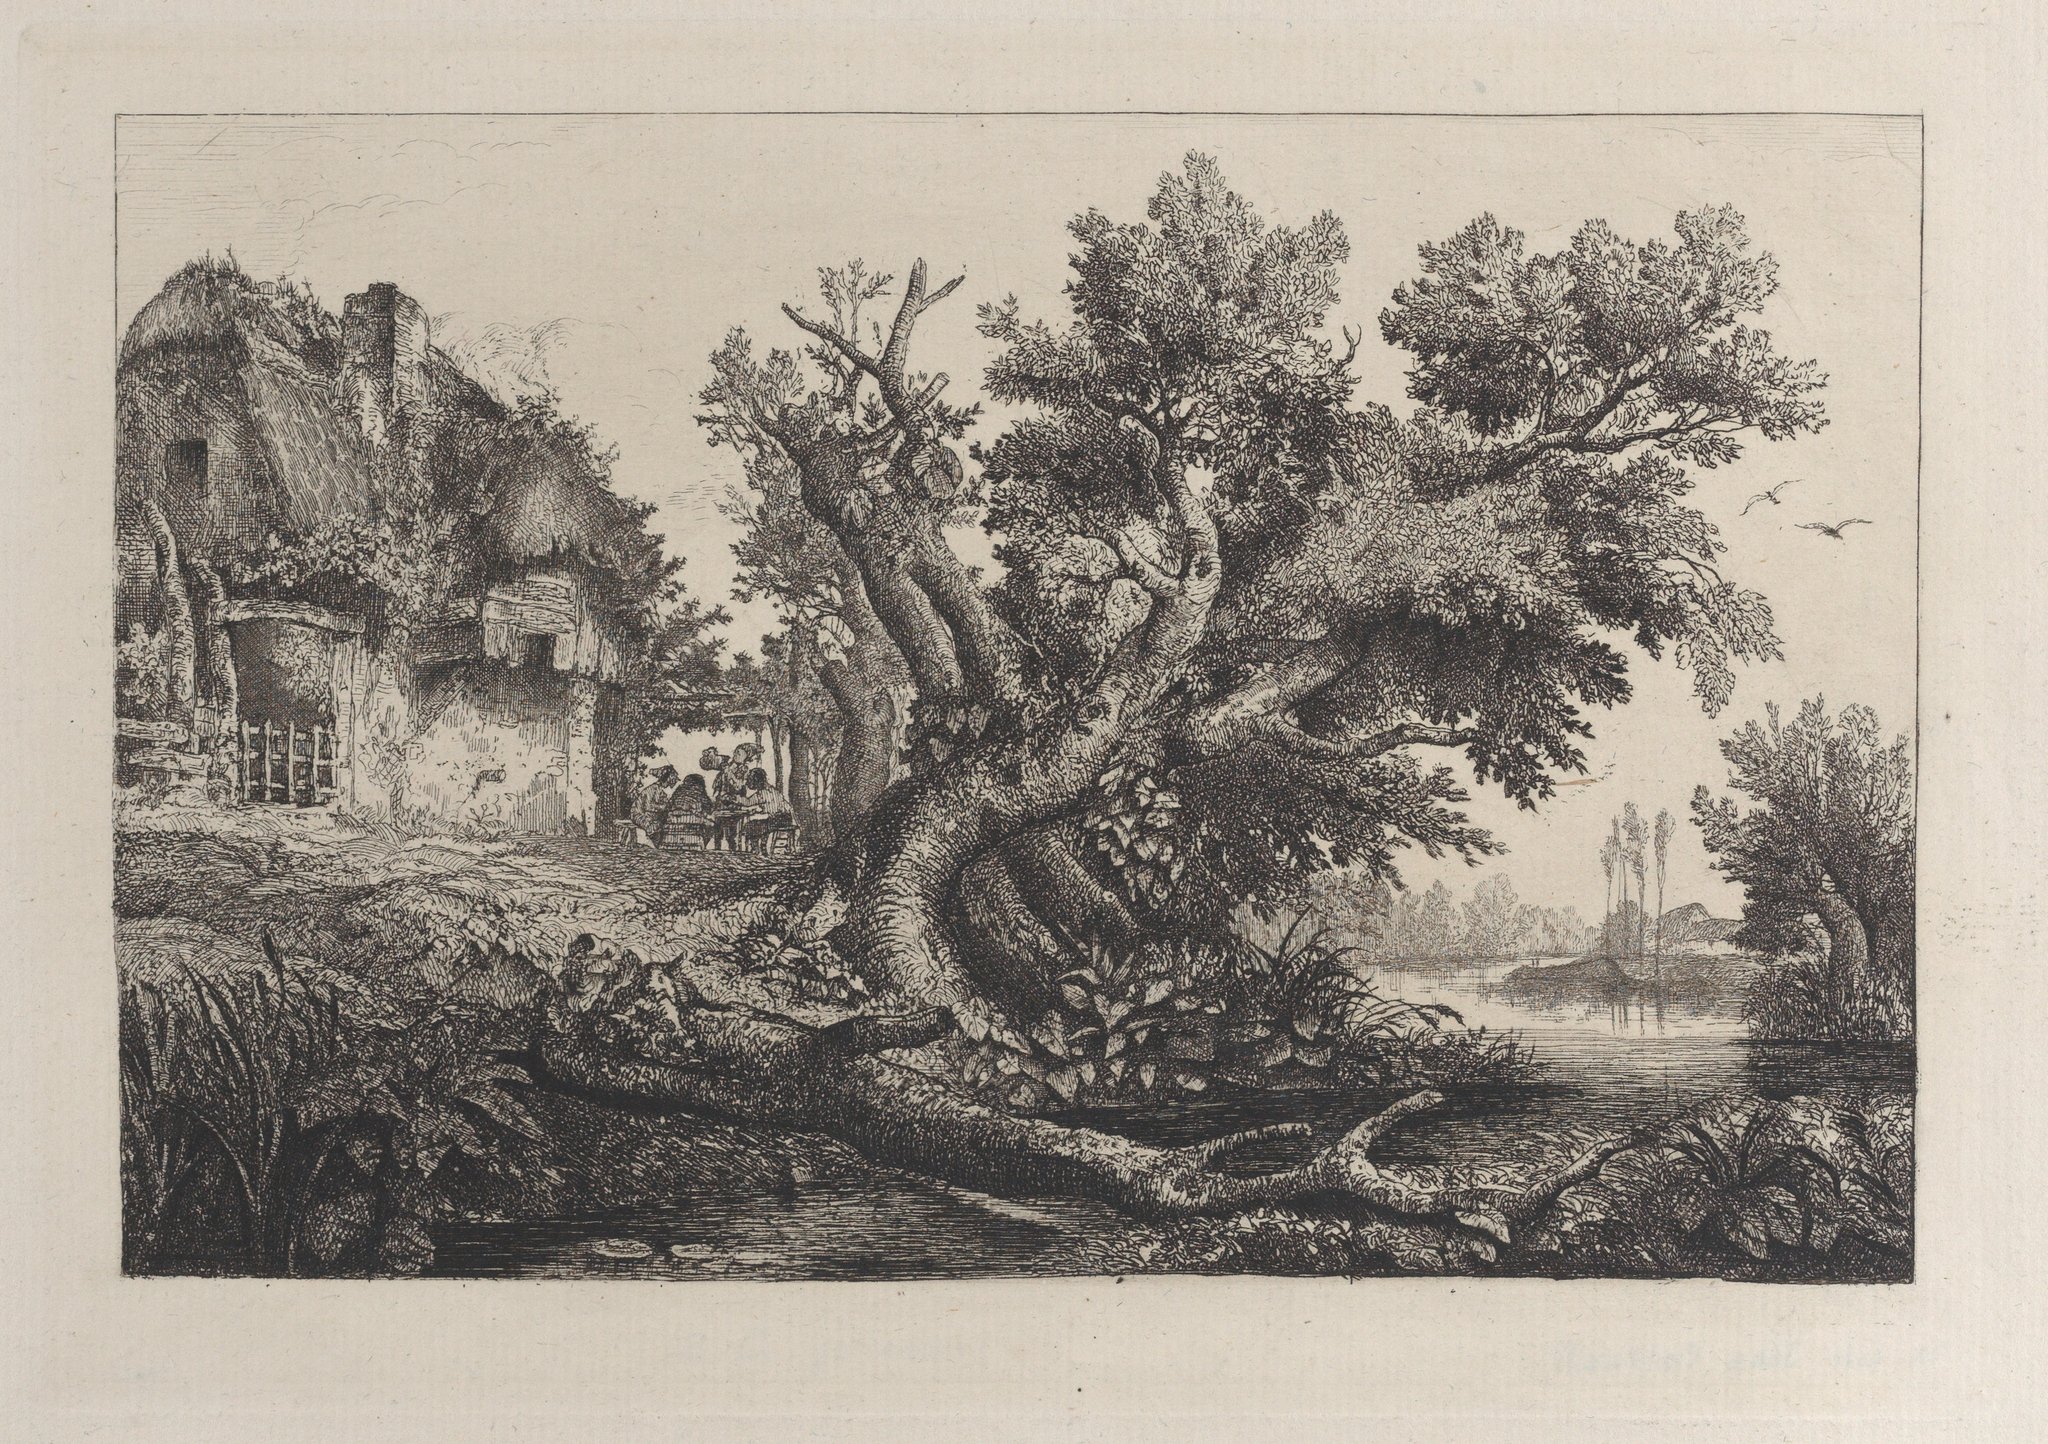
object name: print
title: La Tonnelle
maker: charles-françois daubigny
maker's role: artist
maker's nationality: french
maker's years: 1817-1878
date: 1838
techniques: photogravure